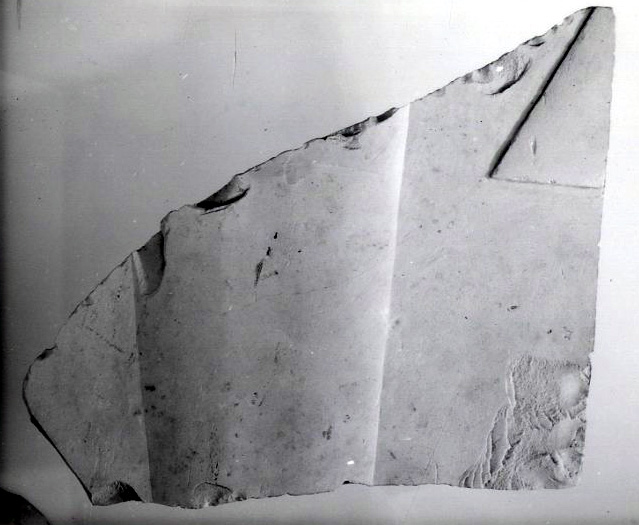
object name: relief fragment, tomb of meketre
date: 1981-1975 BCE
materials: limestone, paint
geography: egypt